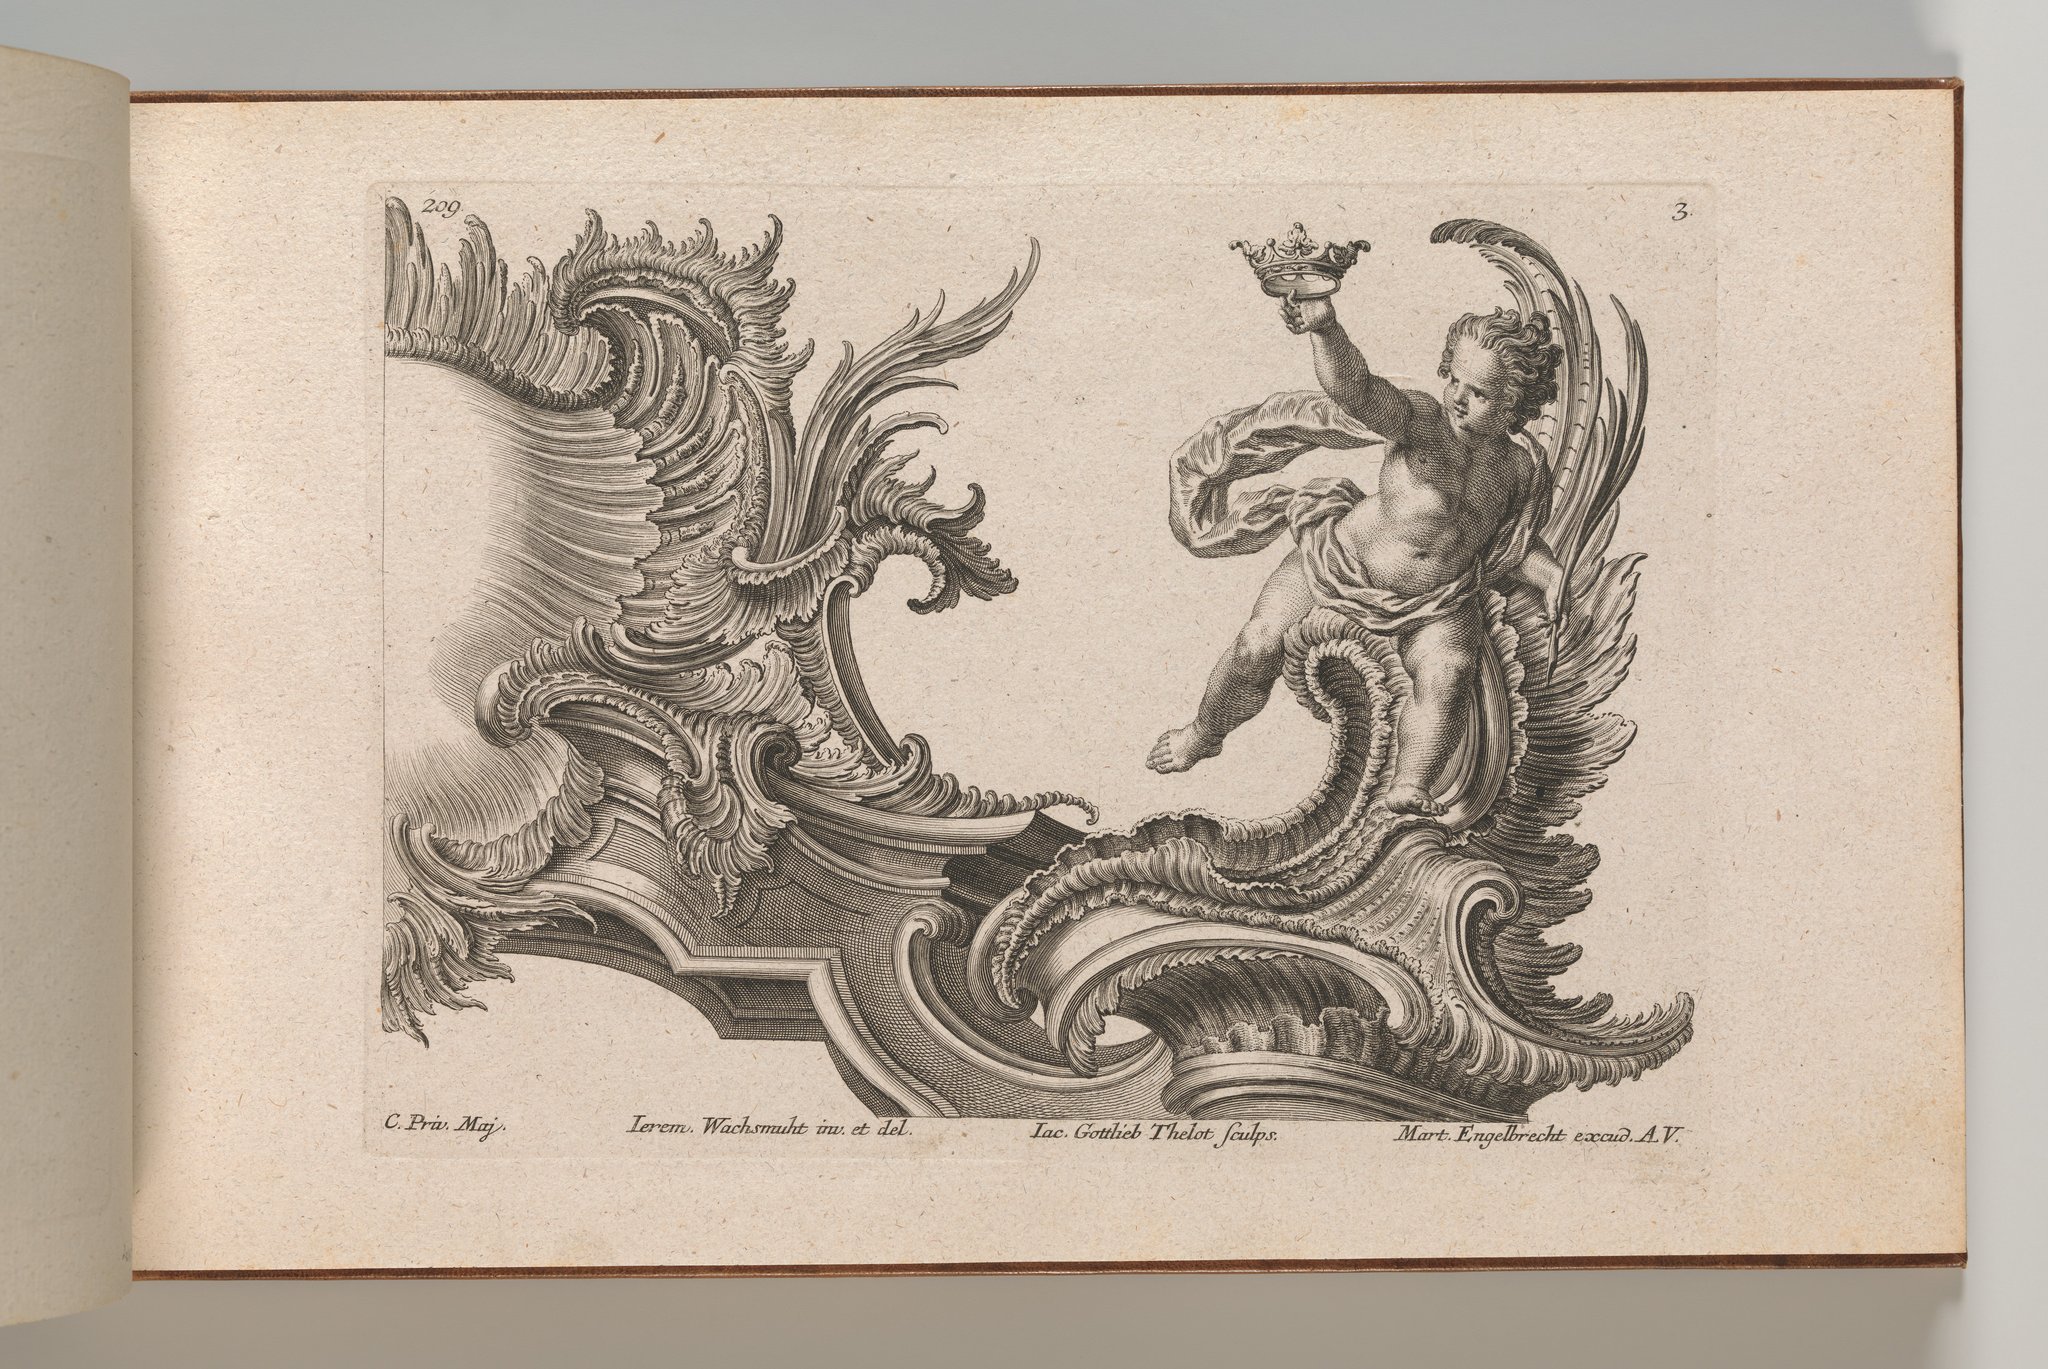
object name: album print ornament architecture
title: Design for a Rocaille Cartouche with the Figure of a Putto, Plate 3 from an untitled series with architectural cartouches and allegorical figures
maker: jacob gottlieb thelot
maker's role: engraver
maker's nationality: central european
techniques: etching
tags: cartouches,ornament,putti